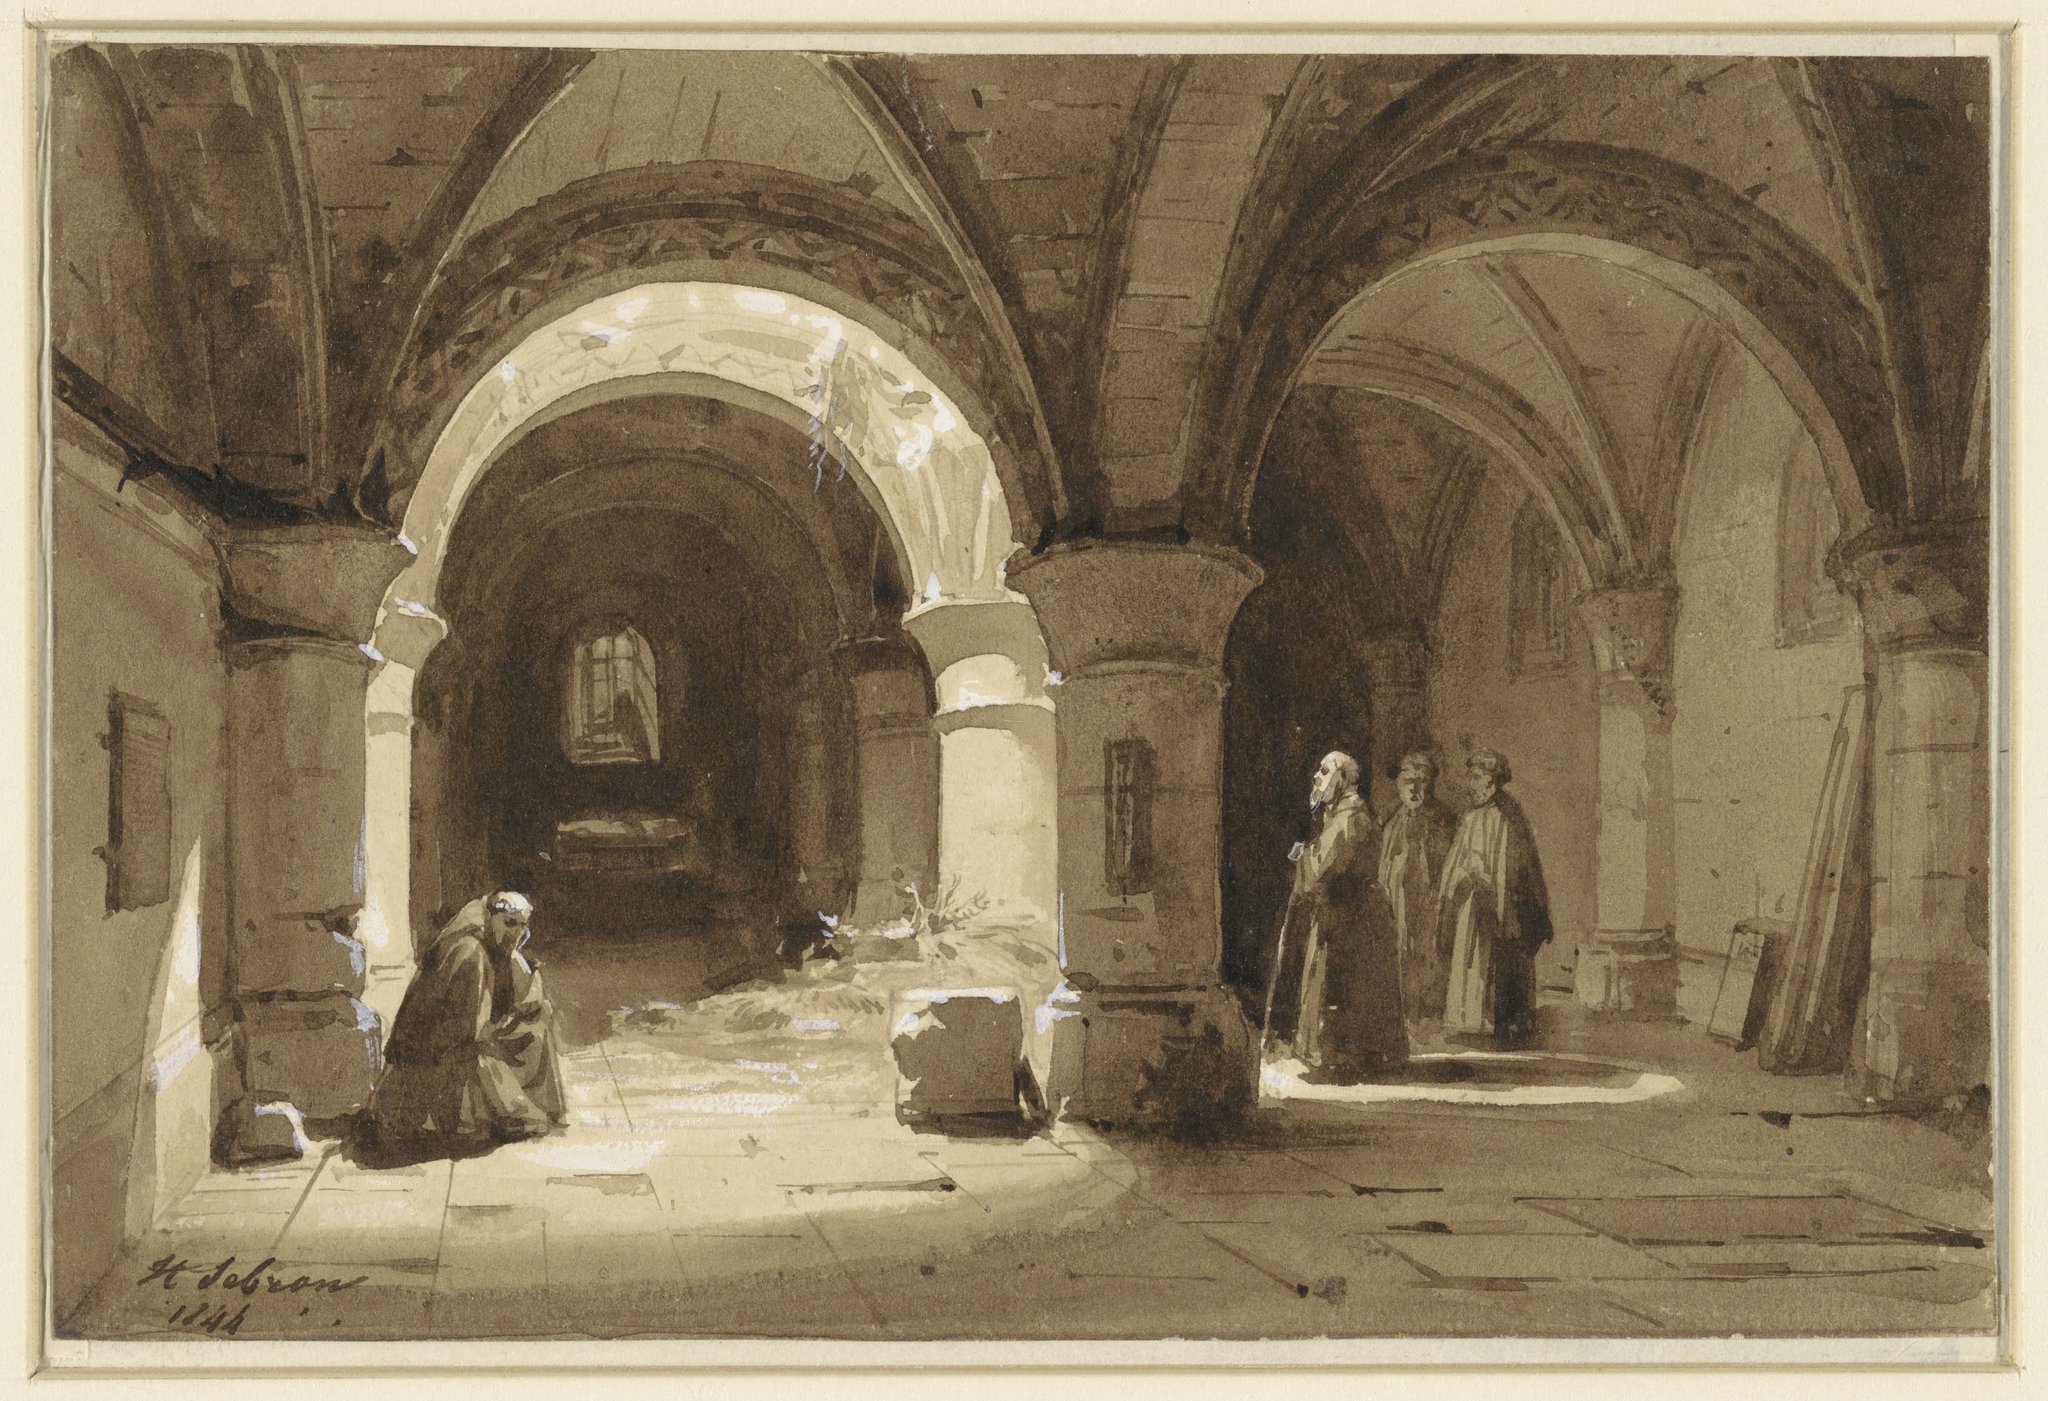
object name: drawing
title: Kloostergewelven met monniken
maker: hippolyte victor valentin sebron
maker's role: draughtsman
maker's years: 1801-1879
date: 1844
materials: ink, paper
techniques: brush, pen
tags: monk(s), friar(s), cloisters ~ monastery